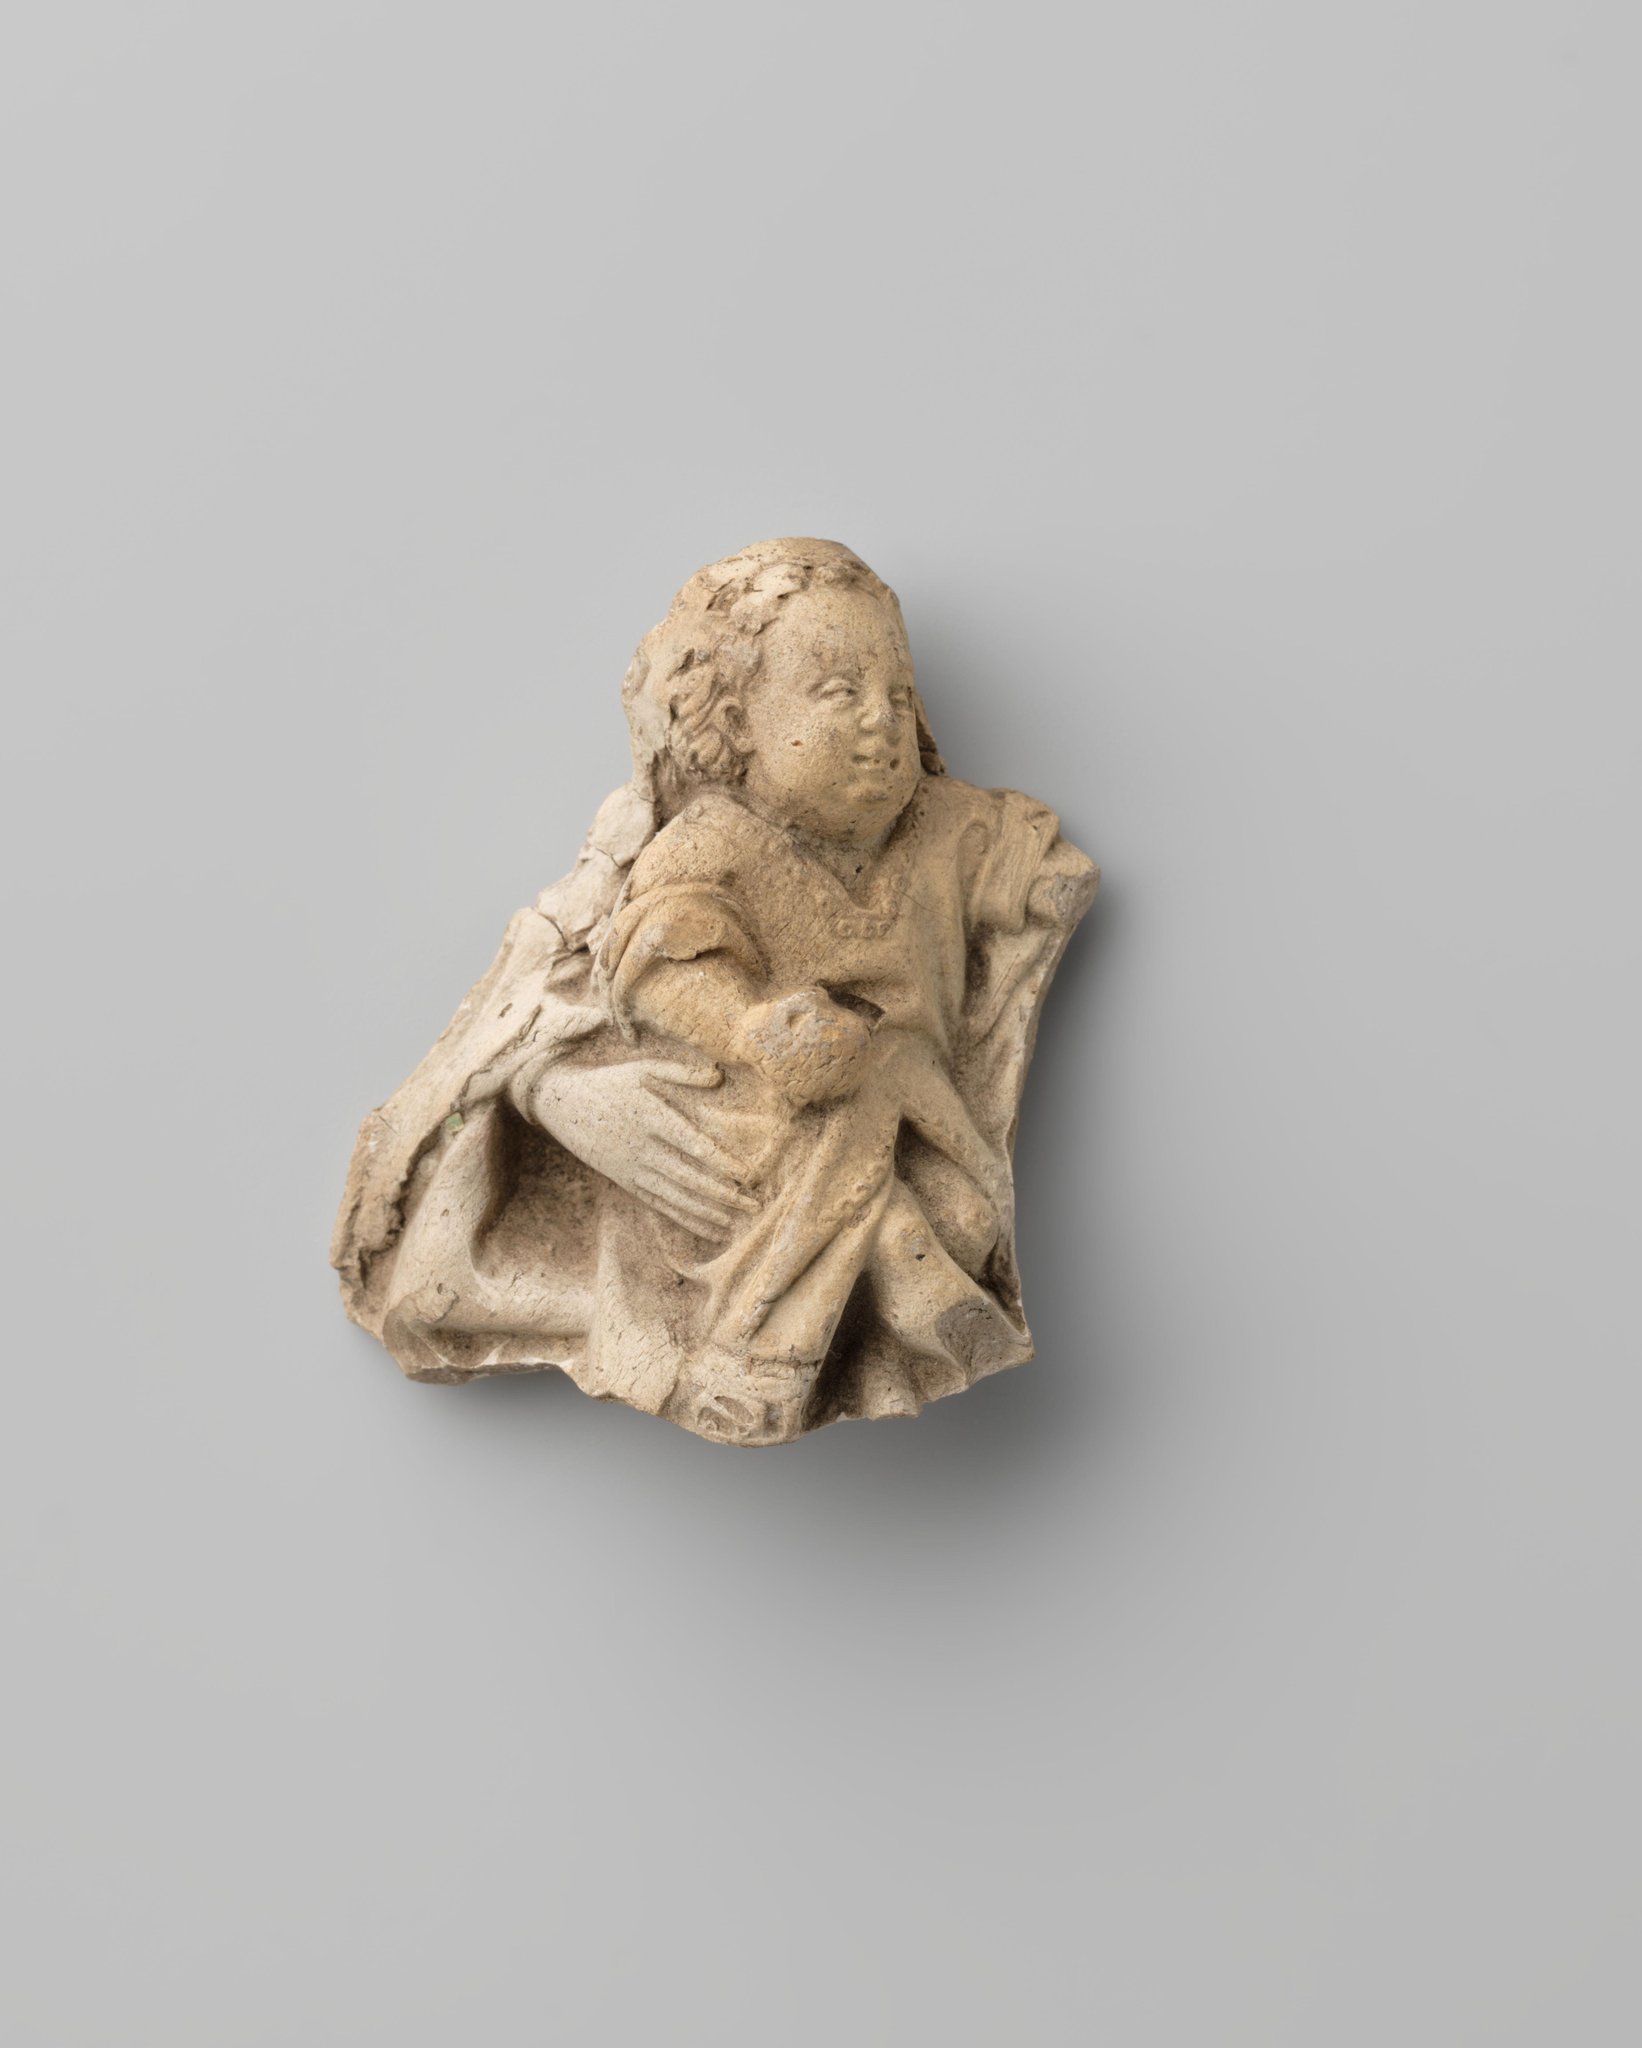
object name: sculpture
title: Christ Child, Fragment of a Virgin and Child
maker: Anonymous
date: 1425-1450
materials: clay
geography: utrecht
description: Christuskind, fragment van een Maria met kind